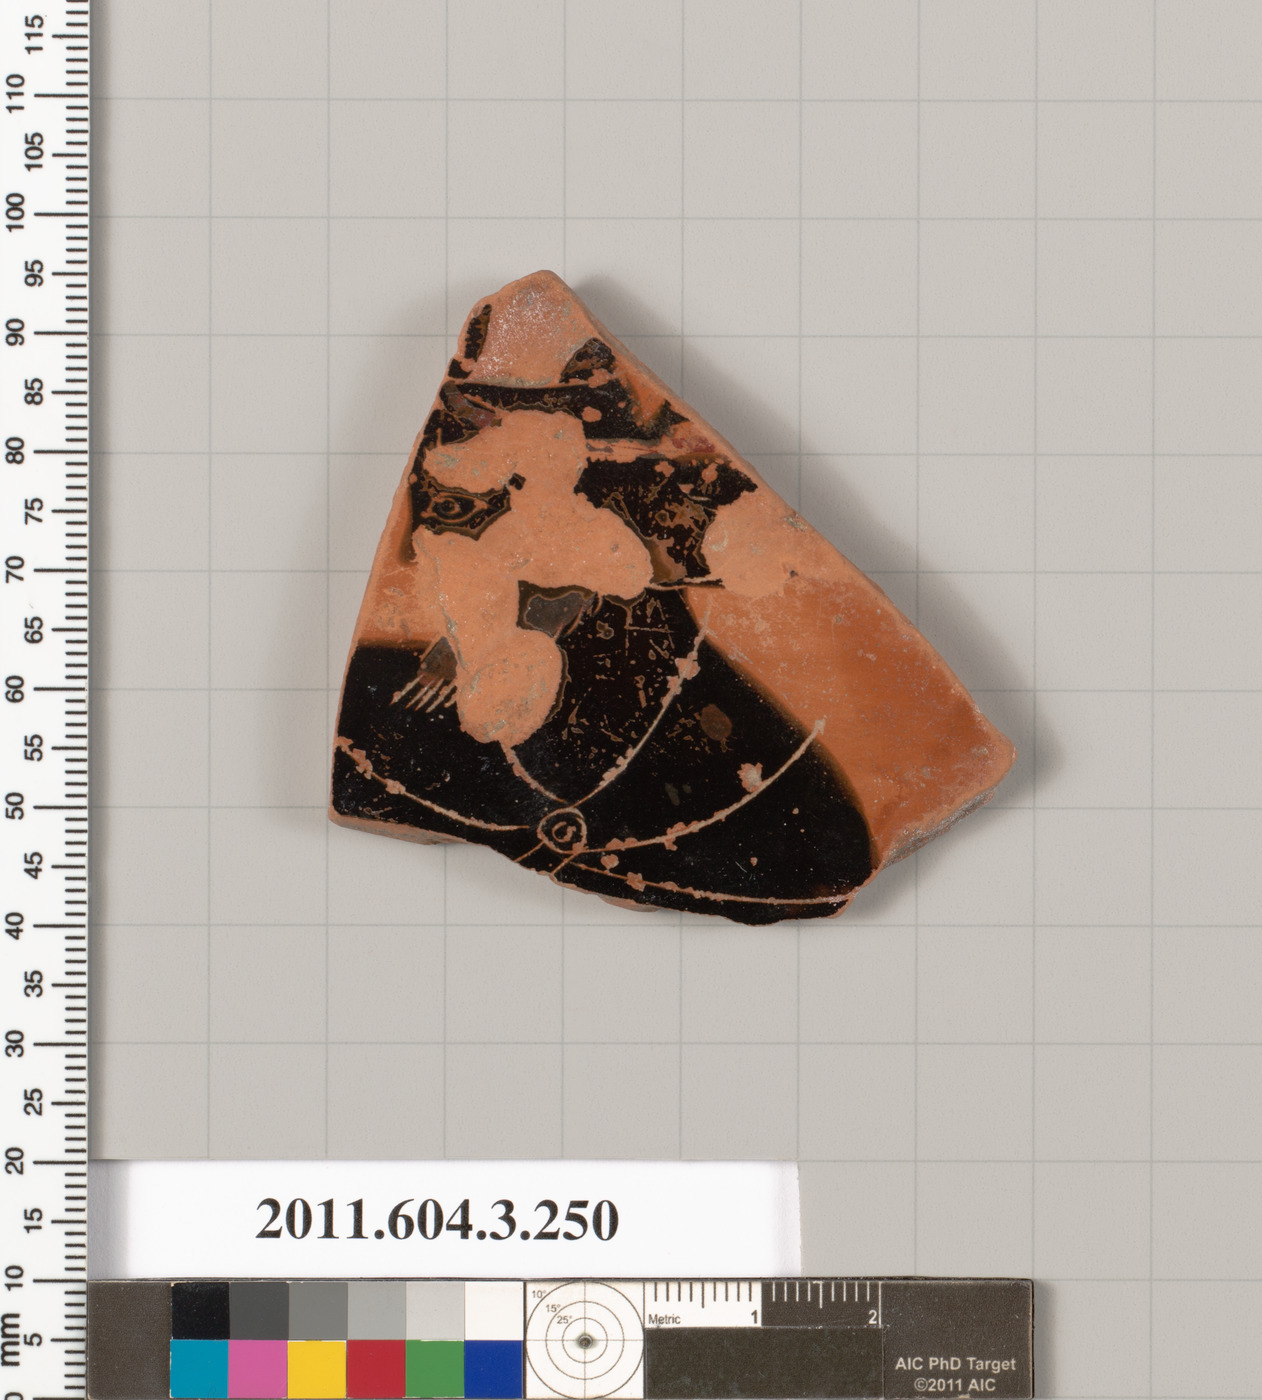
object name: neck amphora fragment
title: Terracotta fragment of a neck-amphora (jar)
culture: greek, attic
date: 510-500 BCE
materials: terracotta